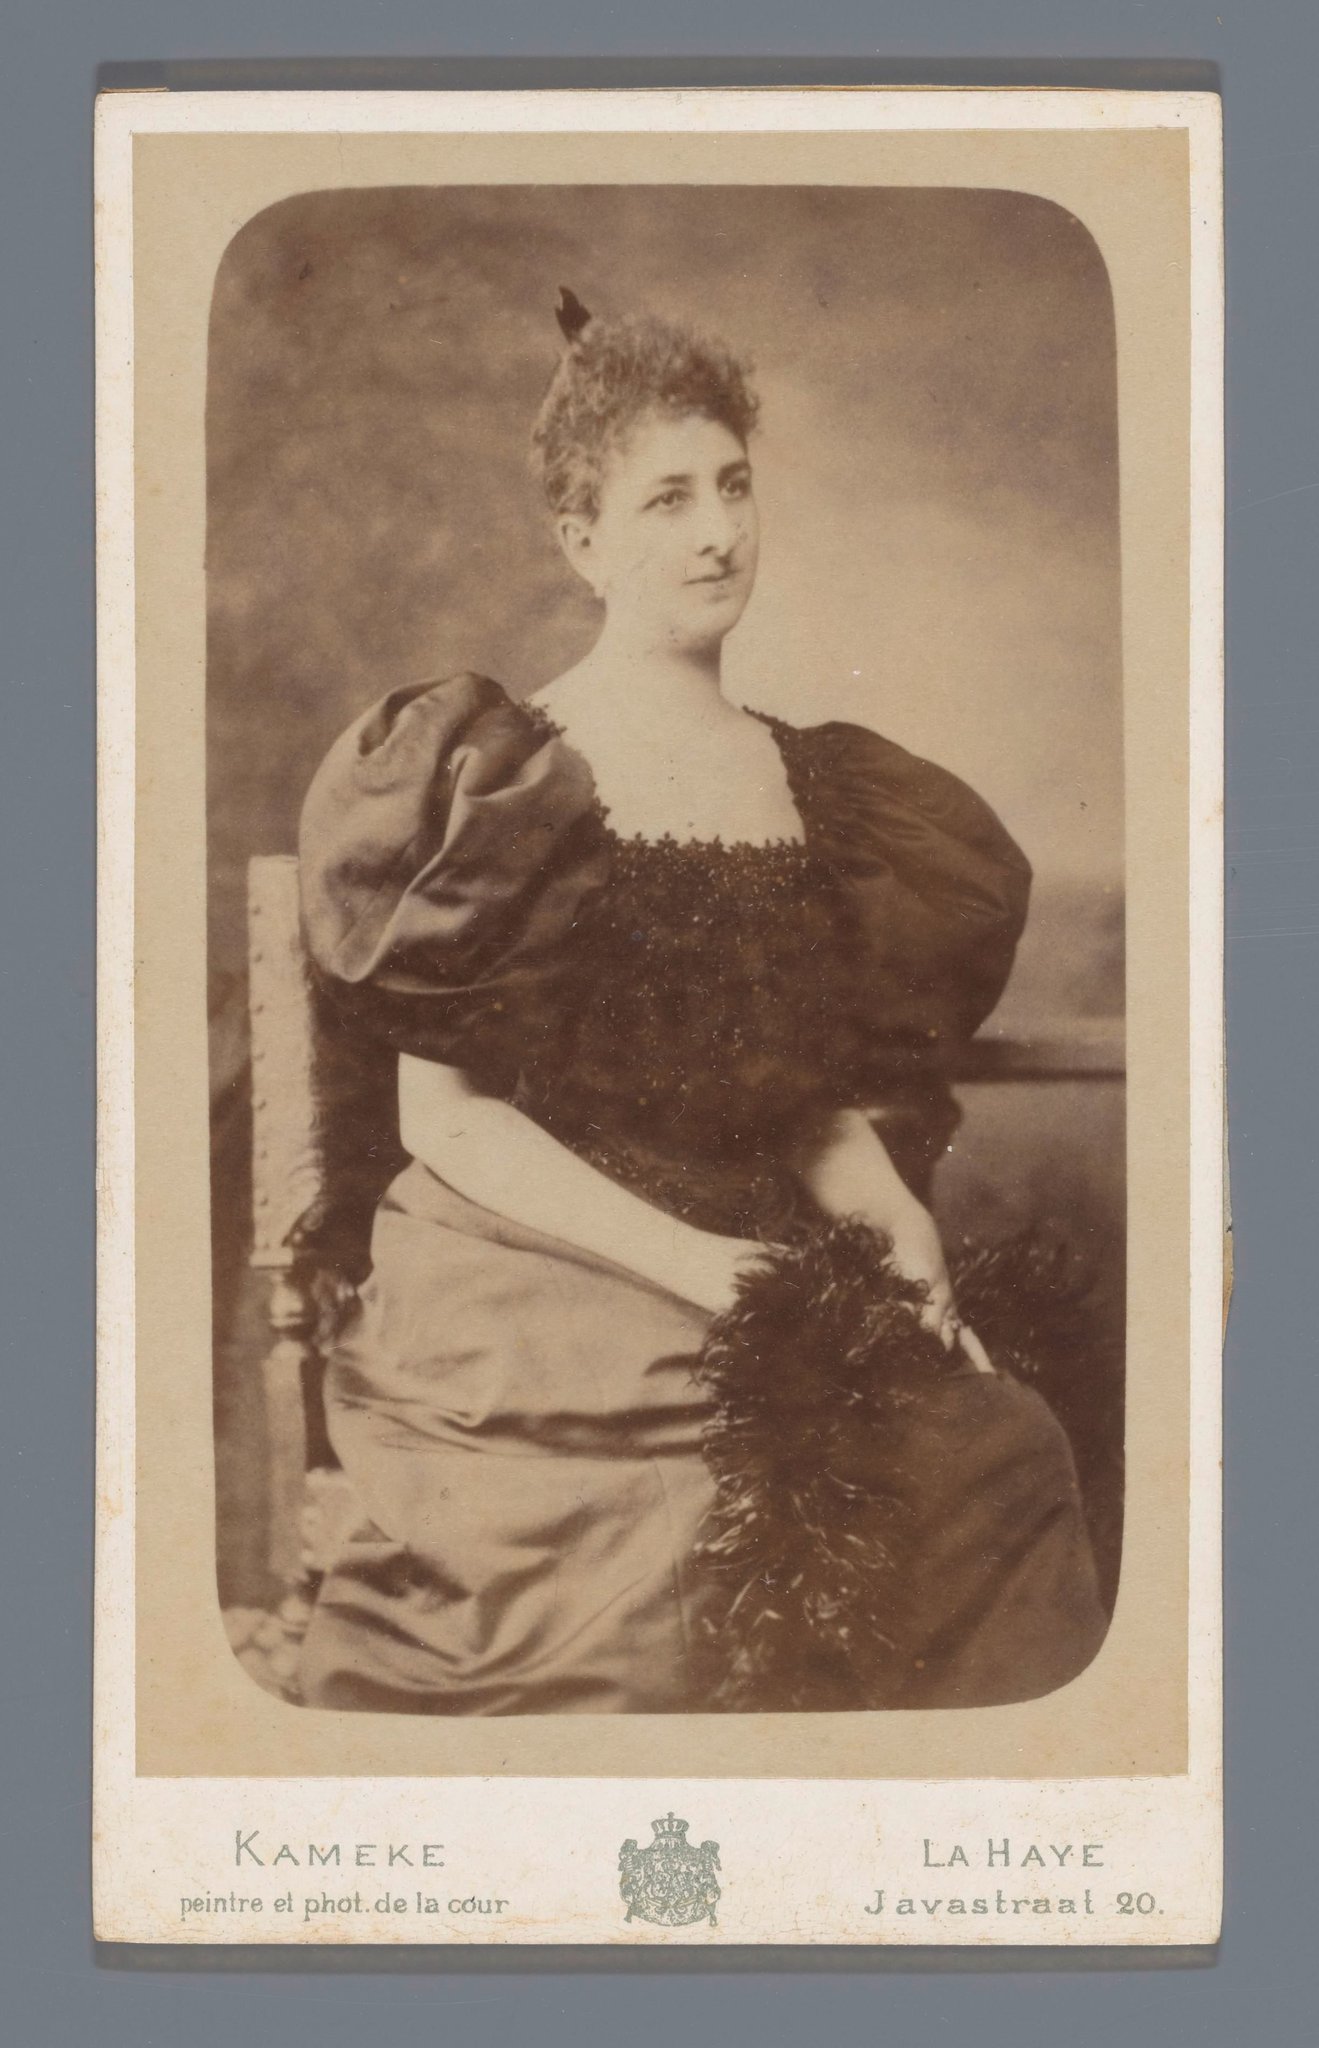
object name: carte de visite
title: Portret van Charlotte van Braam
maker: kameke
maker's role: painter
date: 1887-1898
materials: cardboard, paper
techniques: albumen print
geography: the hague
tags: arnhem, charlotte catharina van braam, historical persons - bb - woman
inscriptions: inscription: ‘C. van Heeckeren/ van Molecate/ -van Braam’, inscription: ‘Charlotte (Loty)’, inscription: ‘KAMEKE/ peintre et phot: de la Cour/ LA HAYE/ Javastraat 20.’